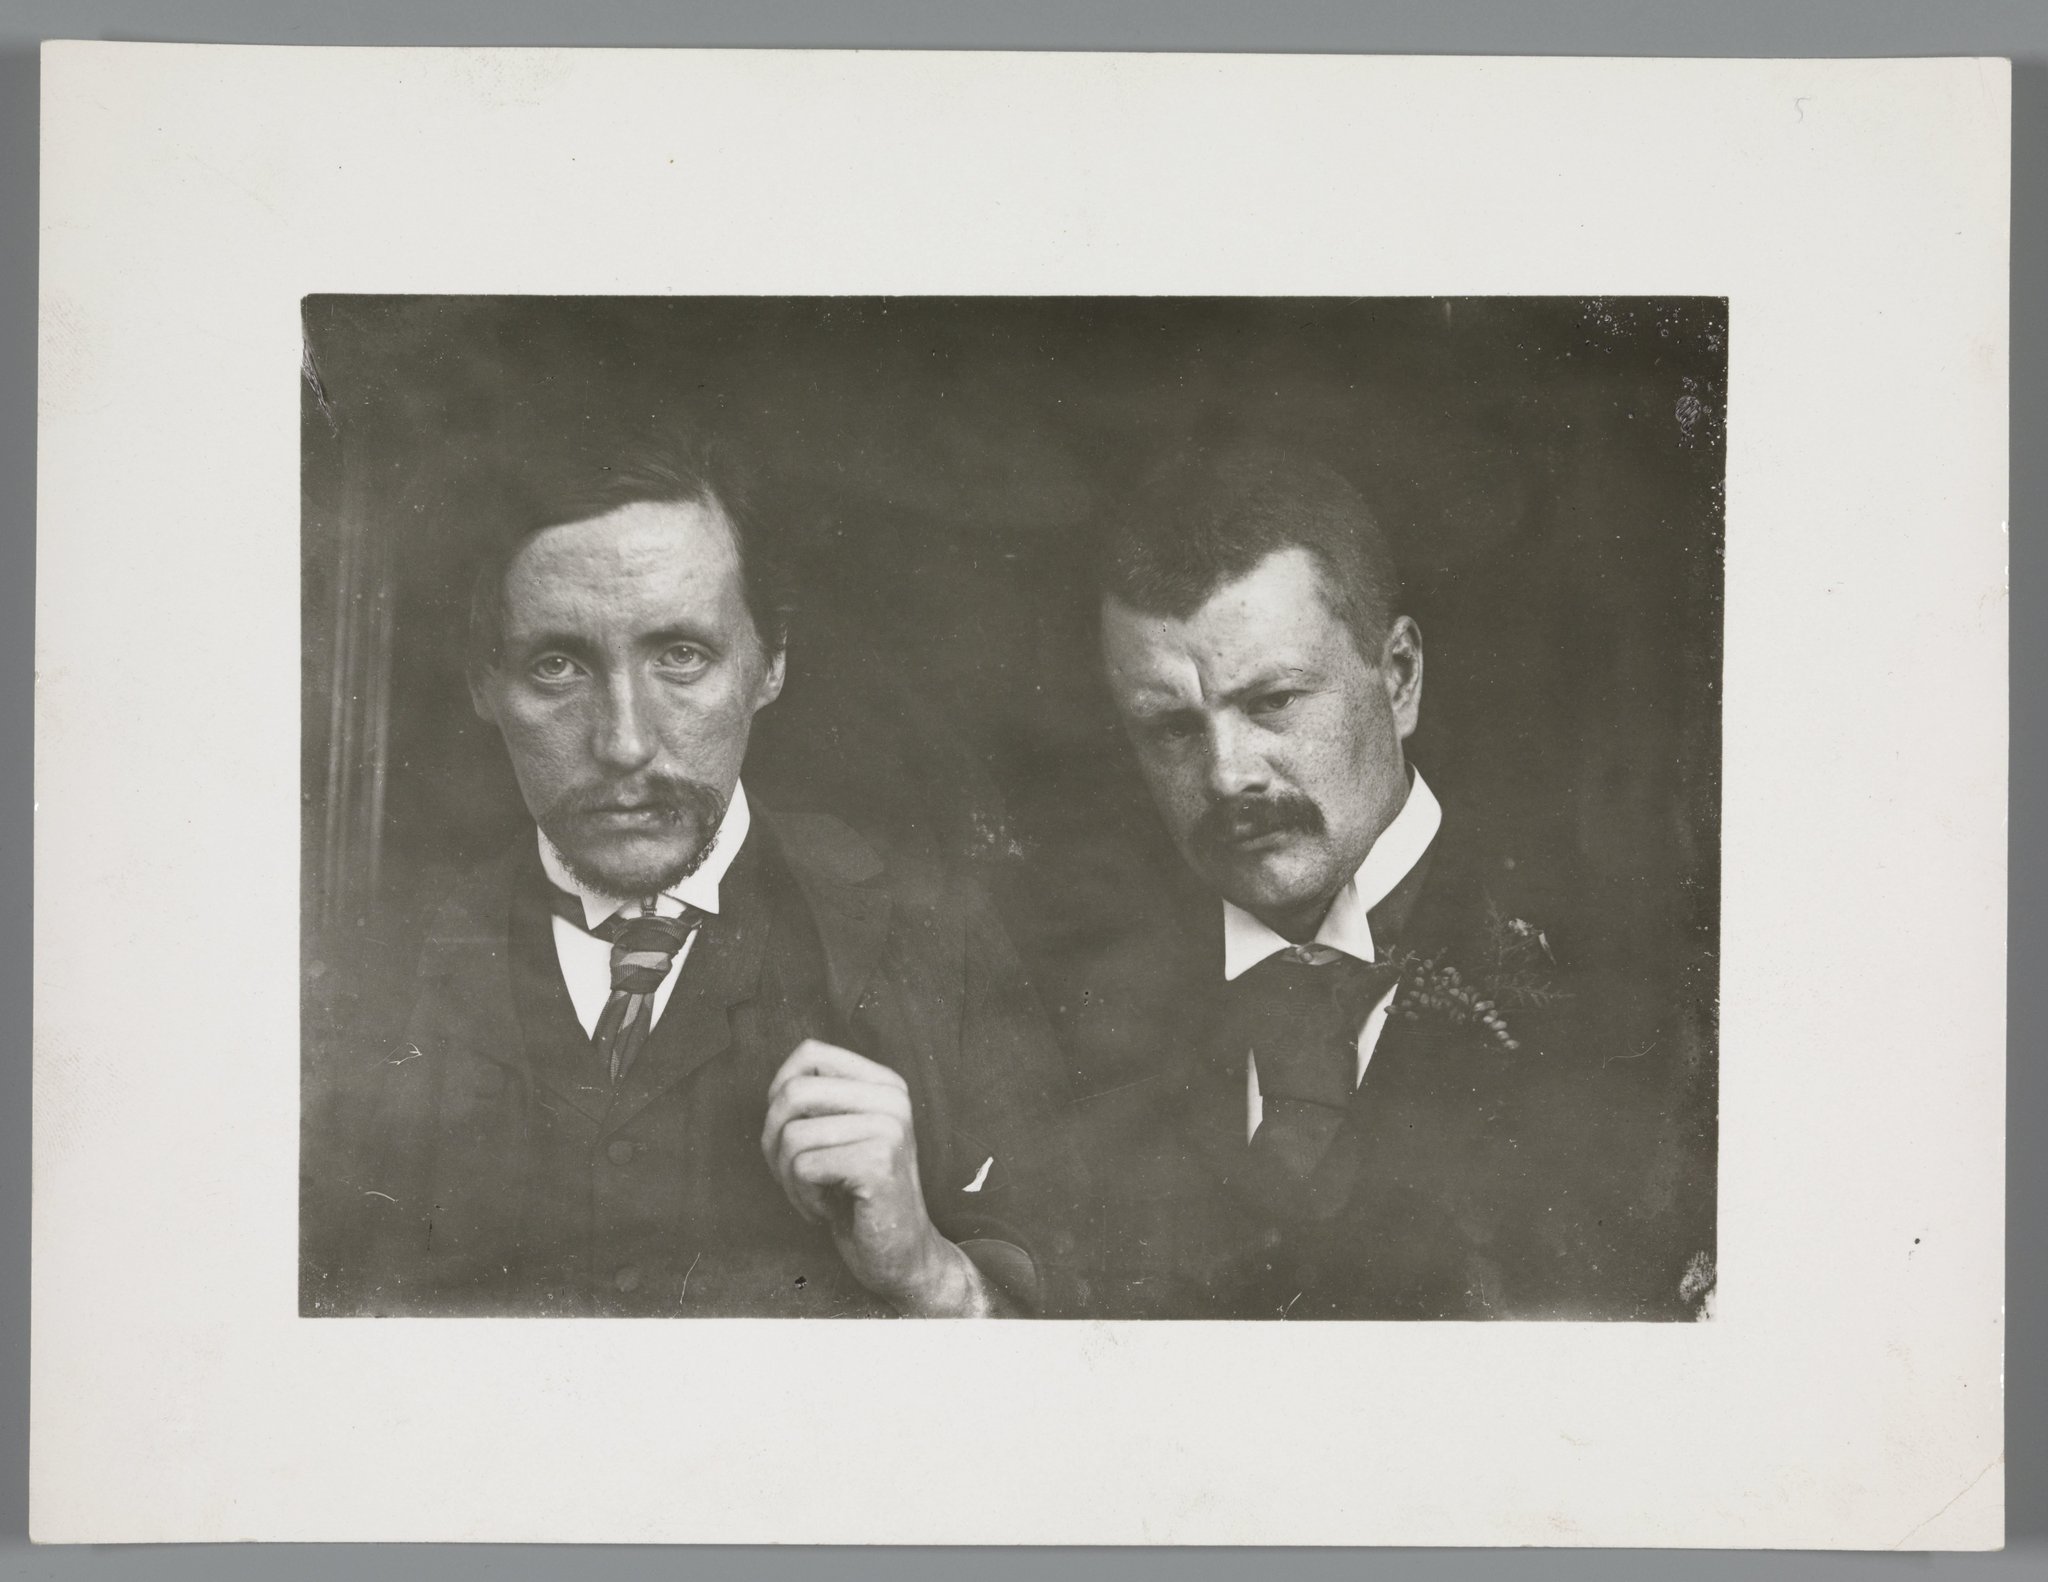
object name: photograph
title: Reproductie naar een foto, schilderij, tekening of prent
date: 1860-1915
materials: paper, photographic support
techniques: gelatin silver print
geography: netherlands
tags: amsterdam, the hague, willem kloos